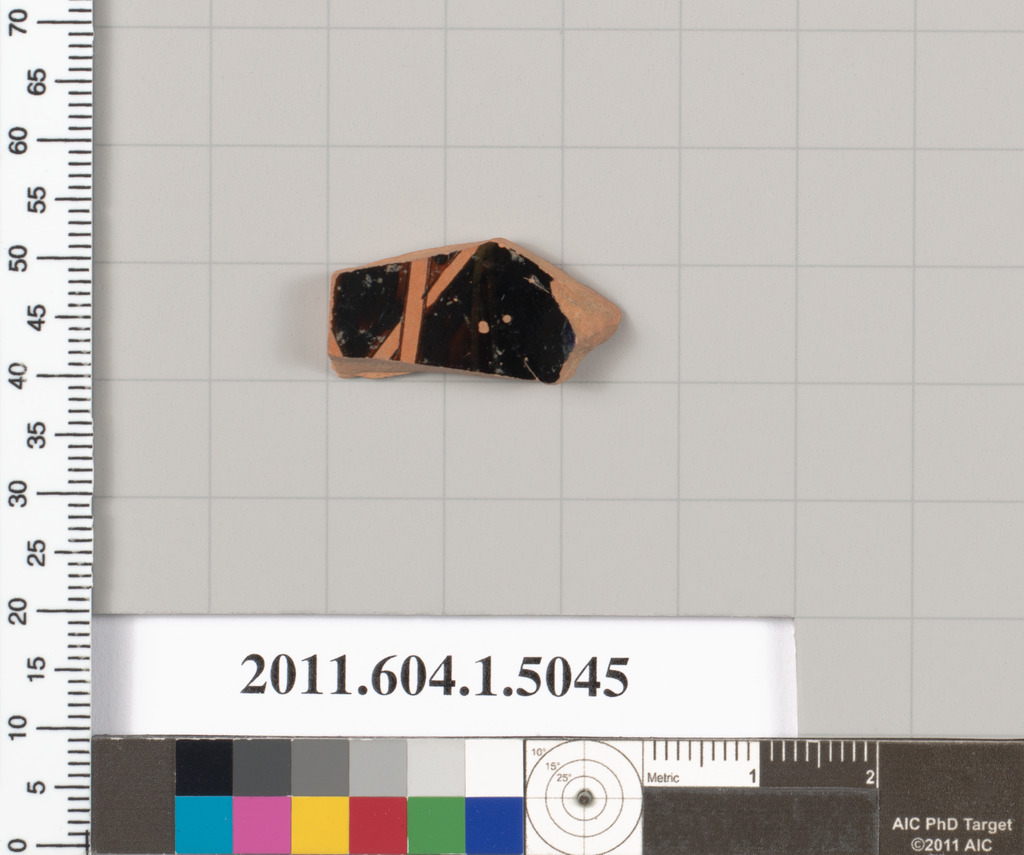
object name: kylix fragment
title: Terracotta fragment of a kylix (drinking cup)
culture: greek, attic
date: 500-480 BCE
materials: terracotta